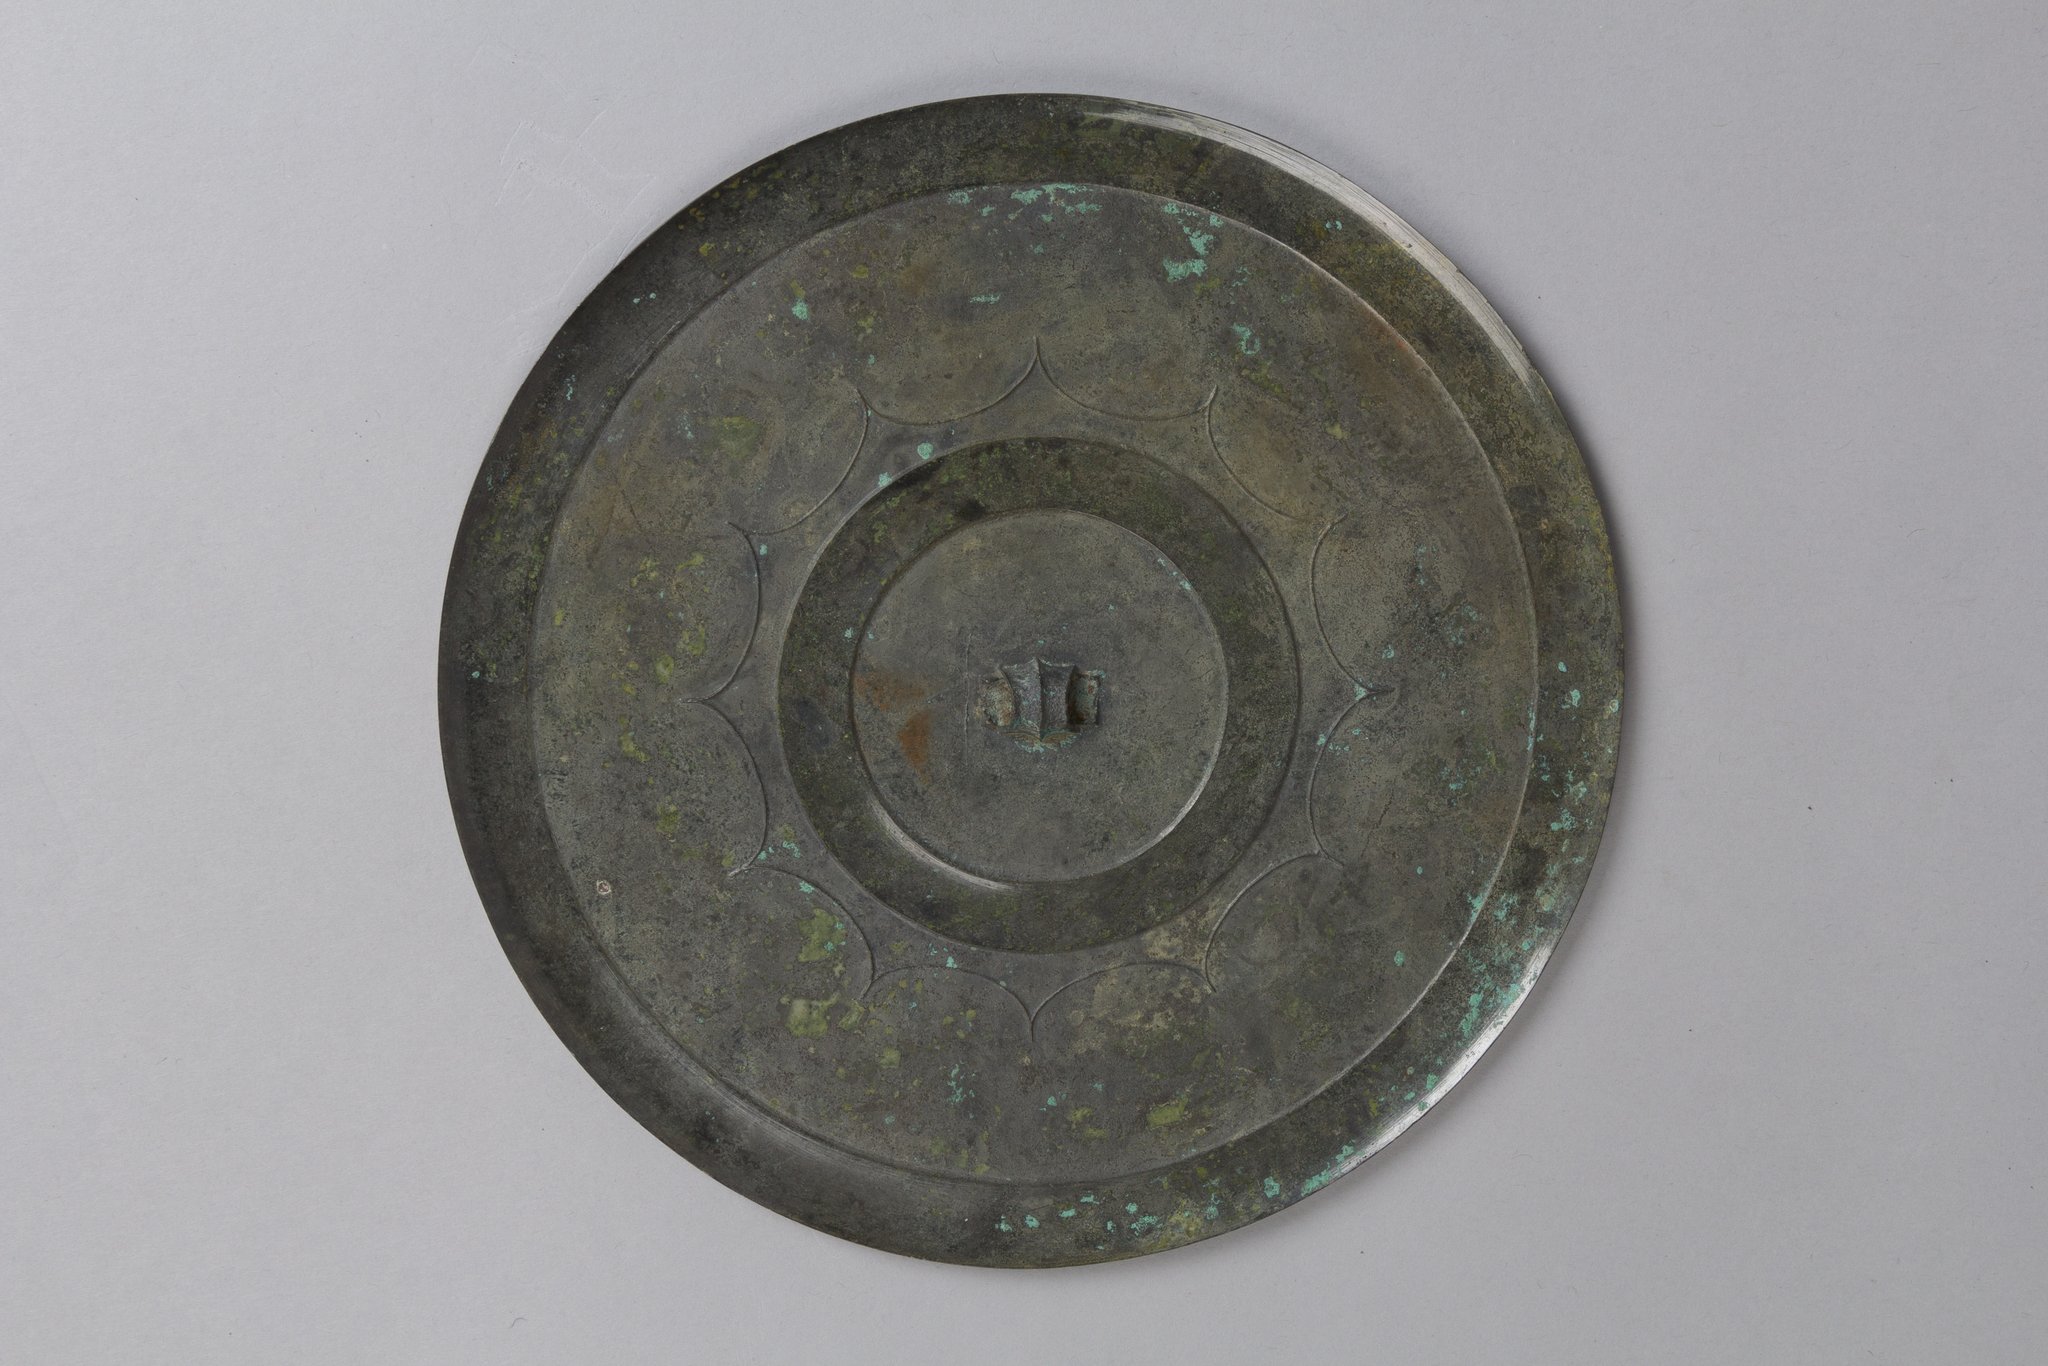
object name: mirror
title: Mirror with twelve-point design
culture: chinese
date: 300-201 BCE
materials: bronze